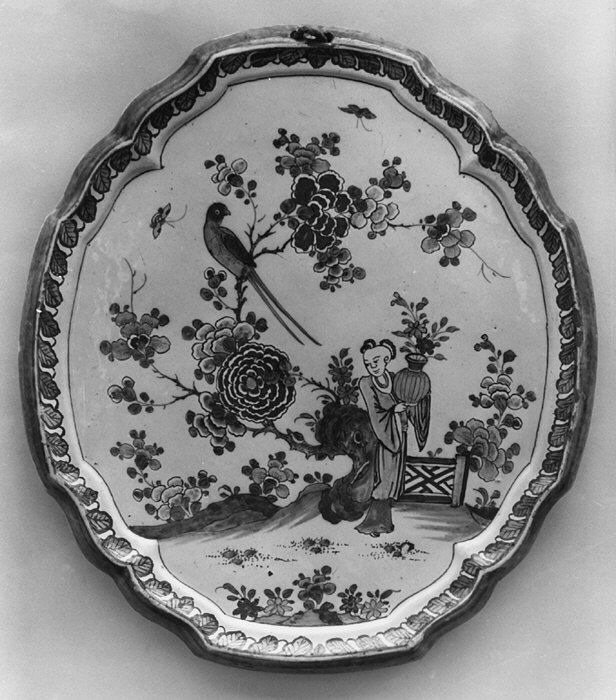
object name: plaque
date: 1700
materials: earthenware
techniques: glazing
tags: birds,chinoiserie,men,butterflies,flowers